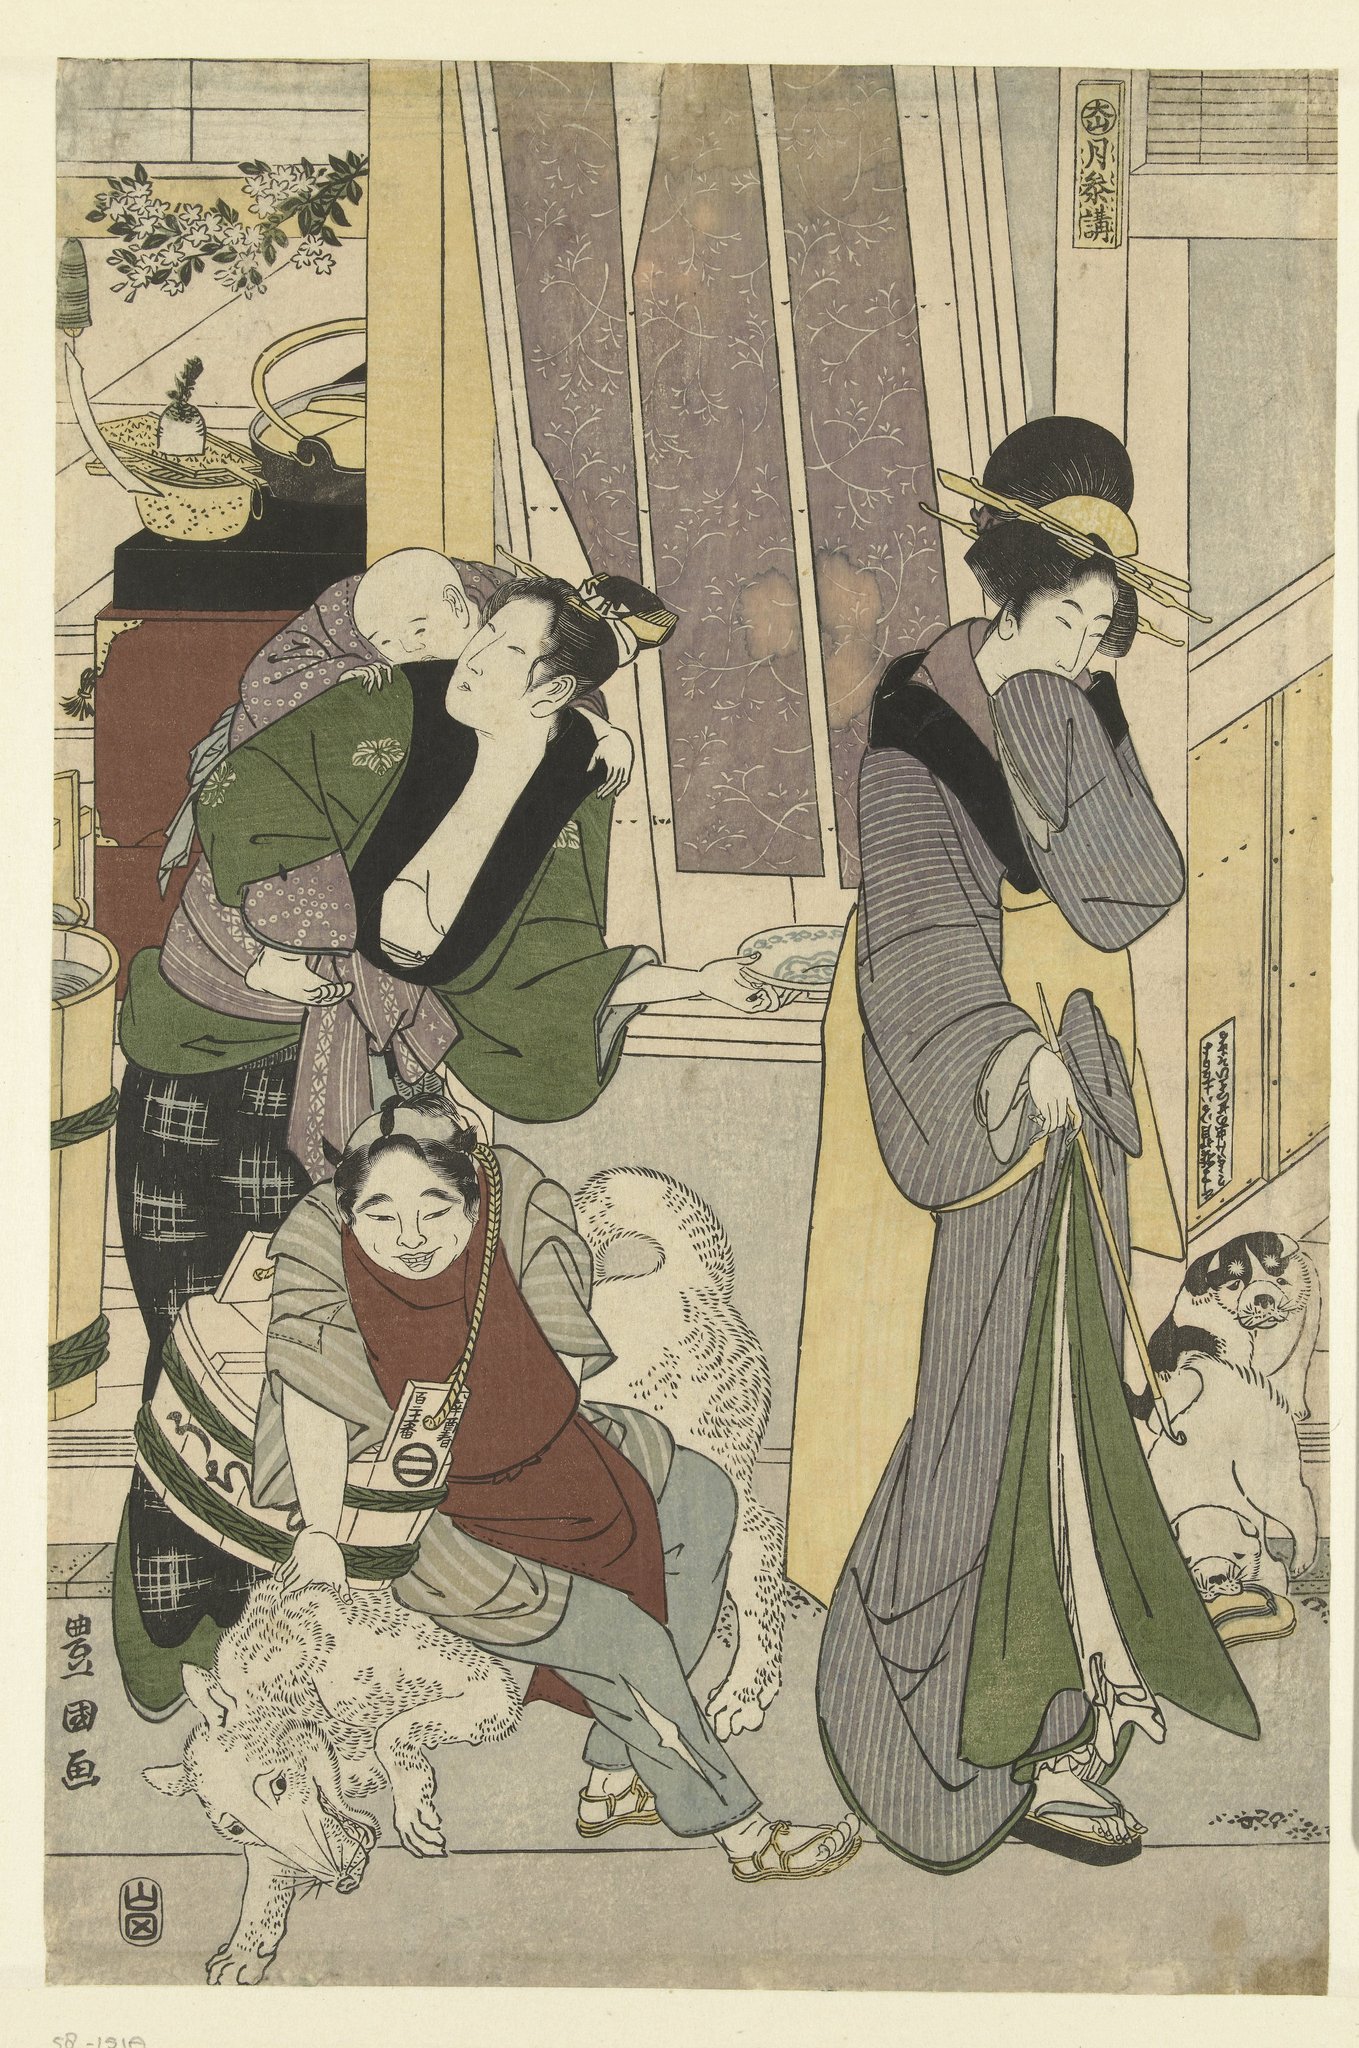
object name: print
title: De vierde maand, een triptiek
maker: utagawa toyokuni (i)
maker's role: print maker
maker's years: 1769-1825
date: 1801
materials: paper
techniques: woodcut, nishiki e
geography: japan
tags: interior of the house, taking care of children, dog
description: Vrouw met pijp in rechter hand, waarachter jongen spelend met hond en vrouw met kind op de rug en schotel in linker hand. Het interieur van een woning op de achtergrond.